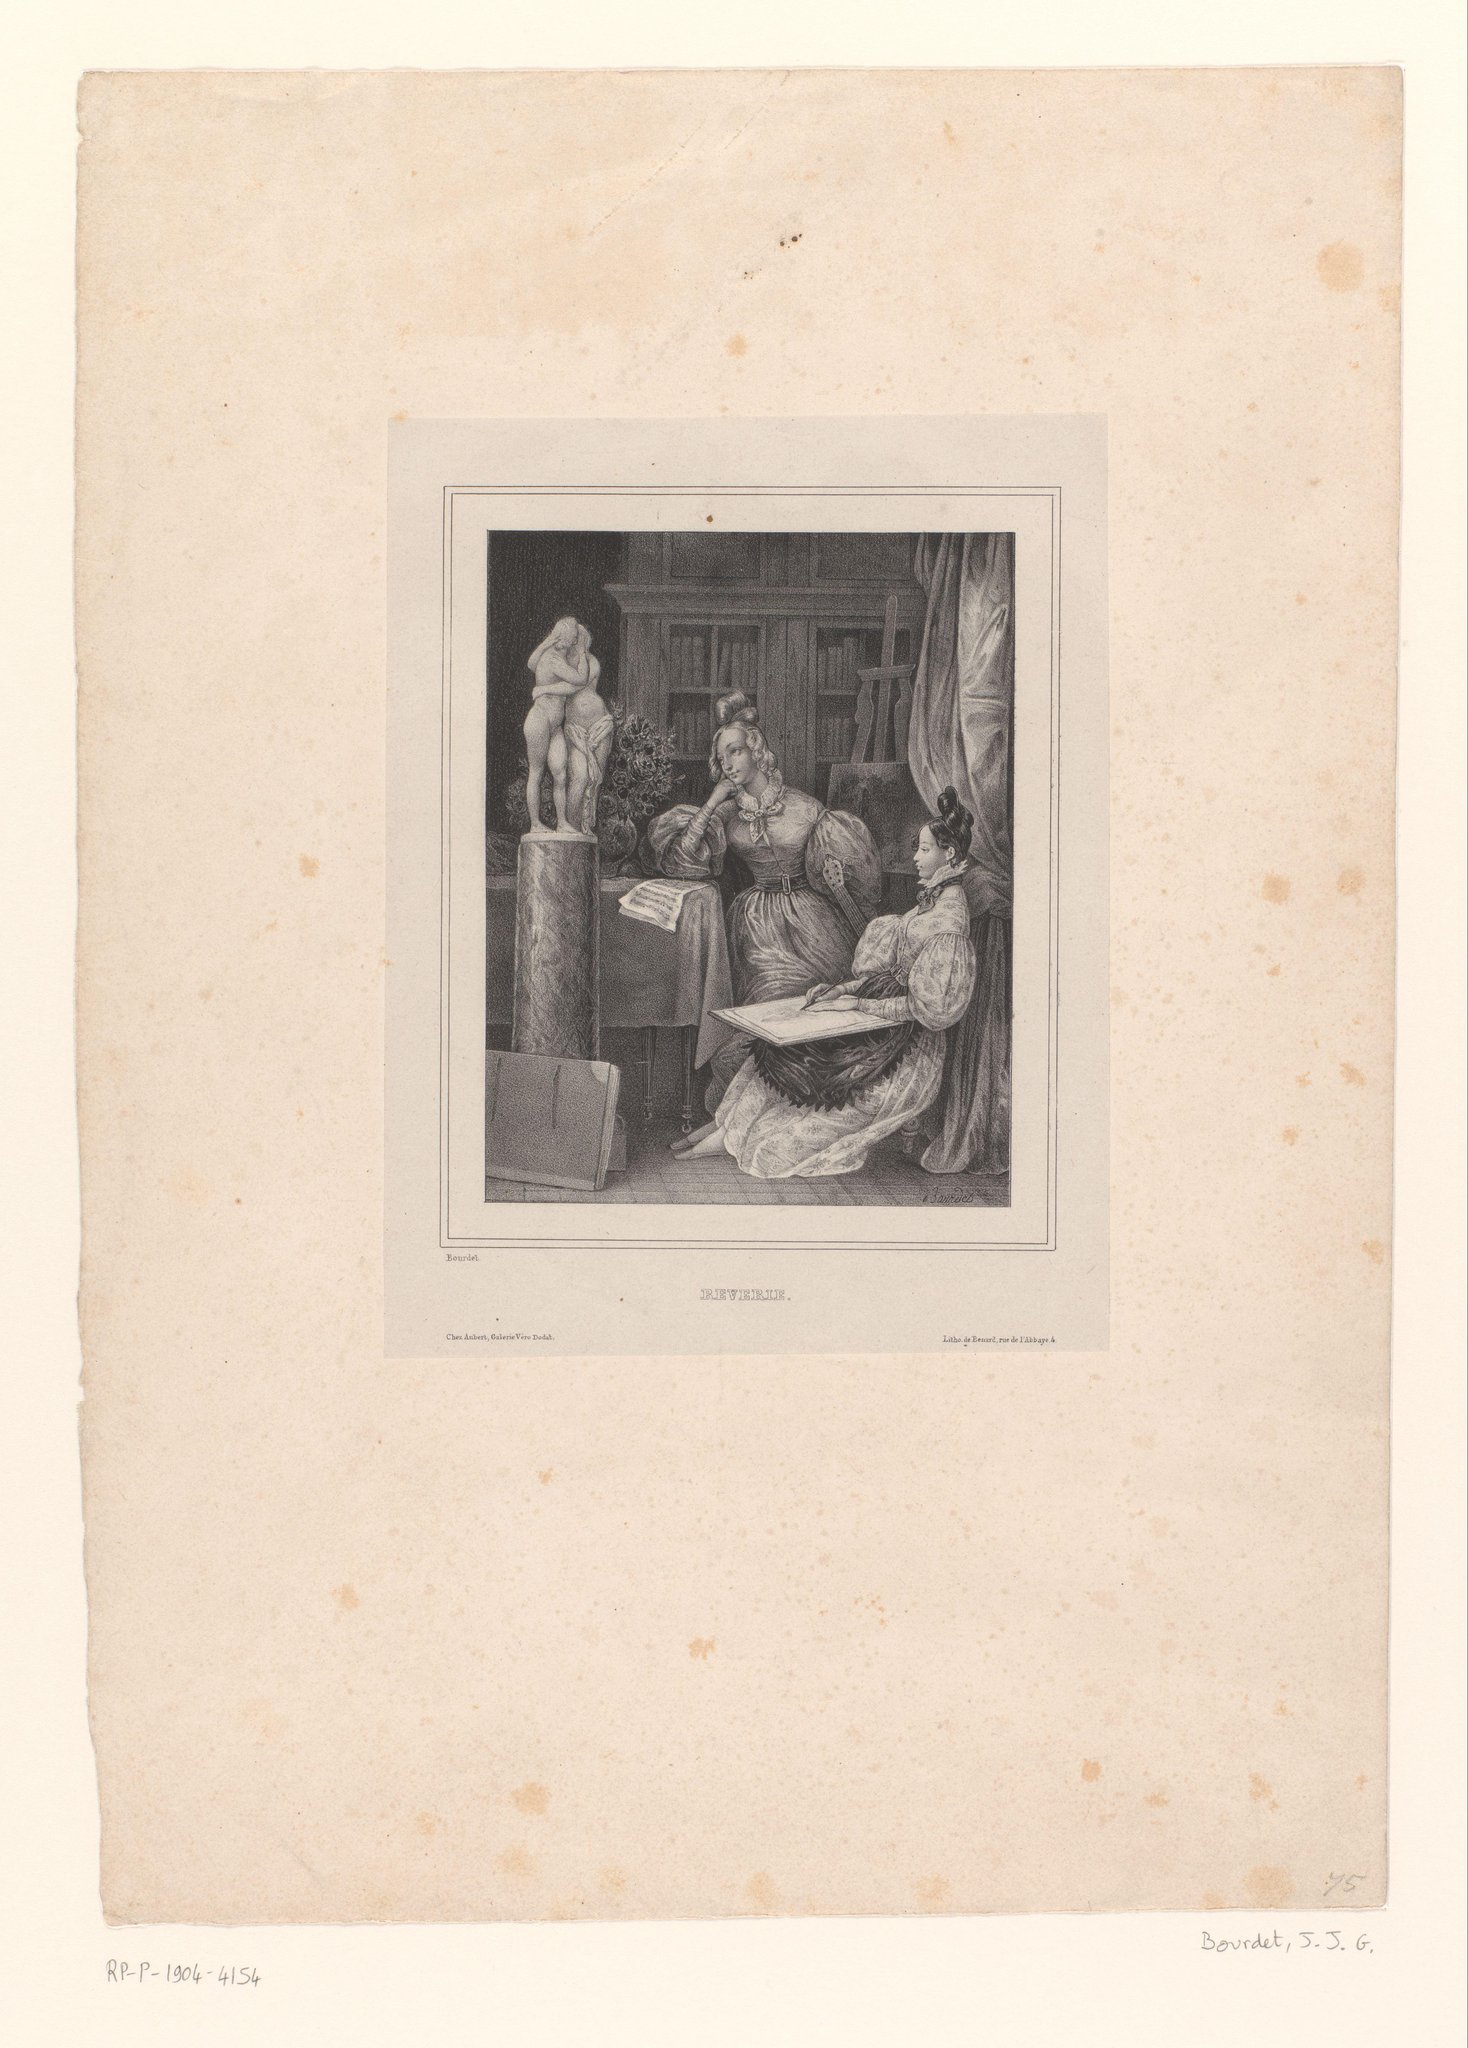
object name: print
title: Rêverie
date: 1832-1850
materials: paper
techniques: lithograph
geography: paris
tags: adolescent, young woman, maiden, dream, amorousness, desire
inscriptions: number: ‘75’, collector's mark: Lugt 2228a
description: Twee jonge vrouwen vermaken zich met tekenen en muziek. Links staat een zuil met een sculptuur van twee naakte geliefden die elkaar omhelzen. De vrouw met de bladmuziek kijkt op naar het beeld, terwijl de andere vrouw met pen en papier voor zich uit staart.